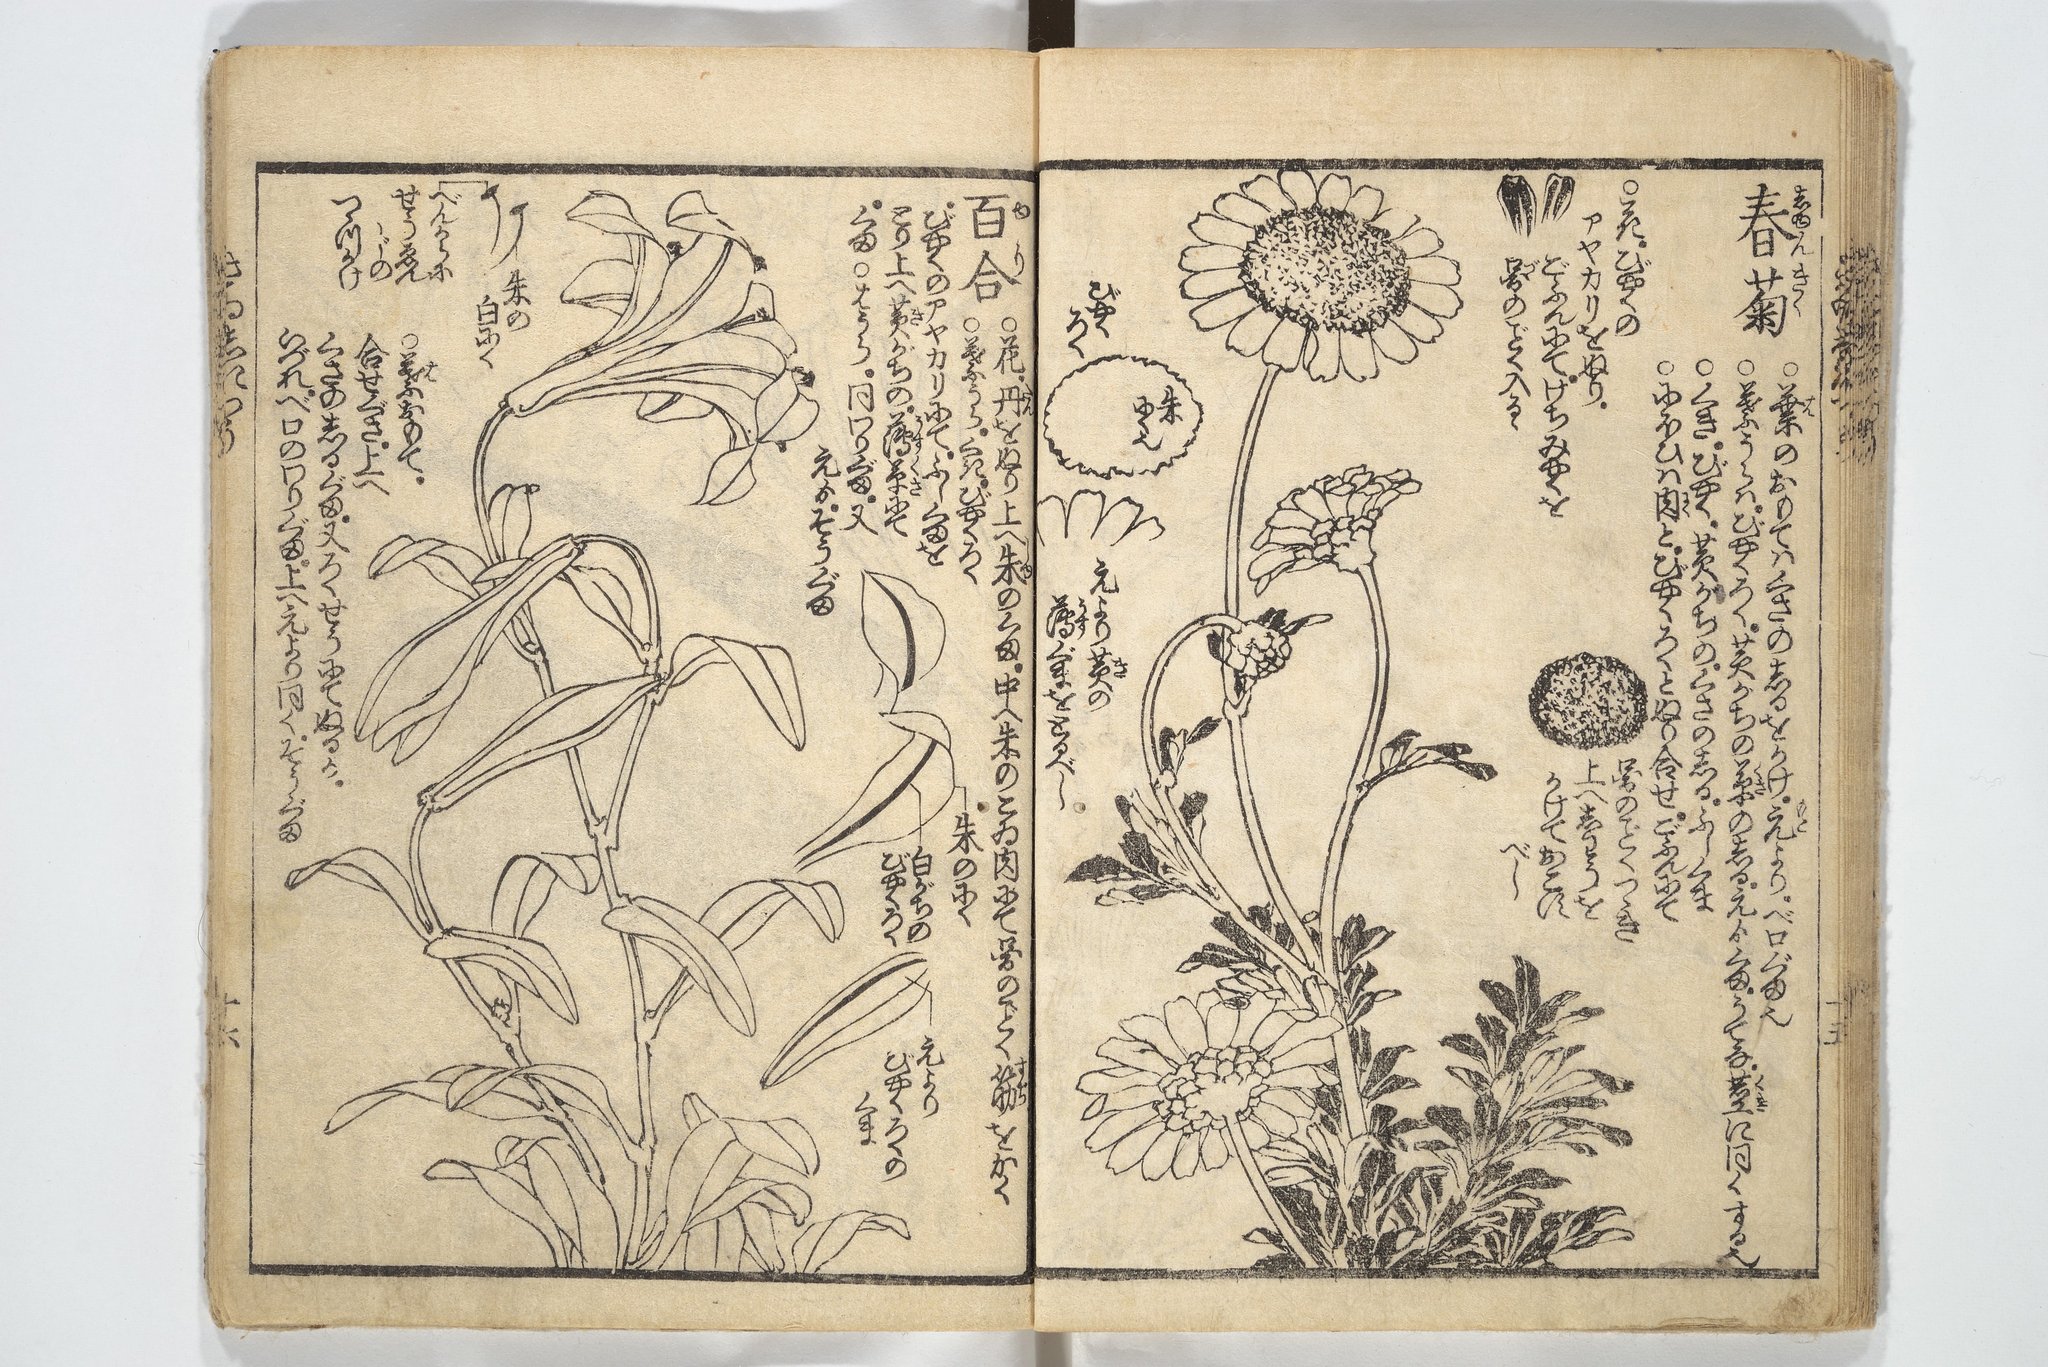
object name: illustrated book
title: Picture Book on the Use of Coloring, first volume (Ehon saishikitsū shohen) 繪本彩色通 初編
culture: japanese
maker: katsushika hokusai 葛飾北斎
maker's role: artist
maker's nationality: japanese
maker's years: 1760-1849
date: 1848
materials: ink, paper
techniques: woodblock print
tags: birds,flowers